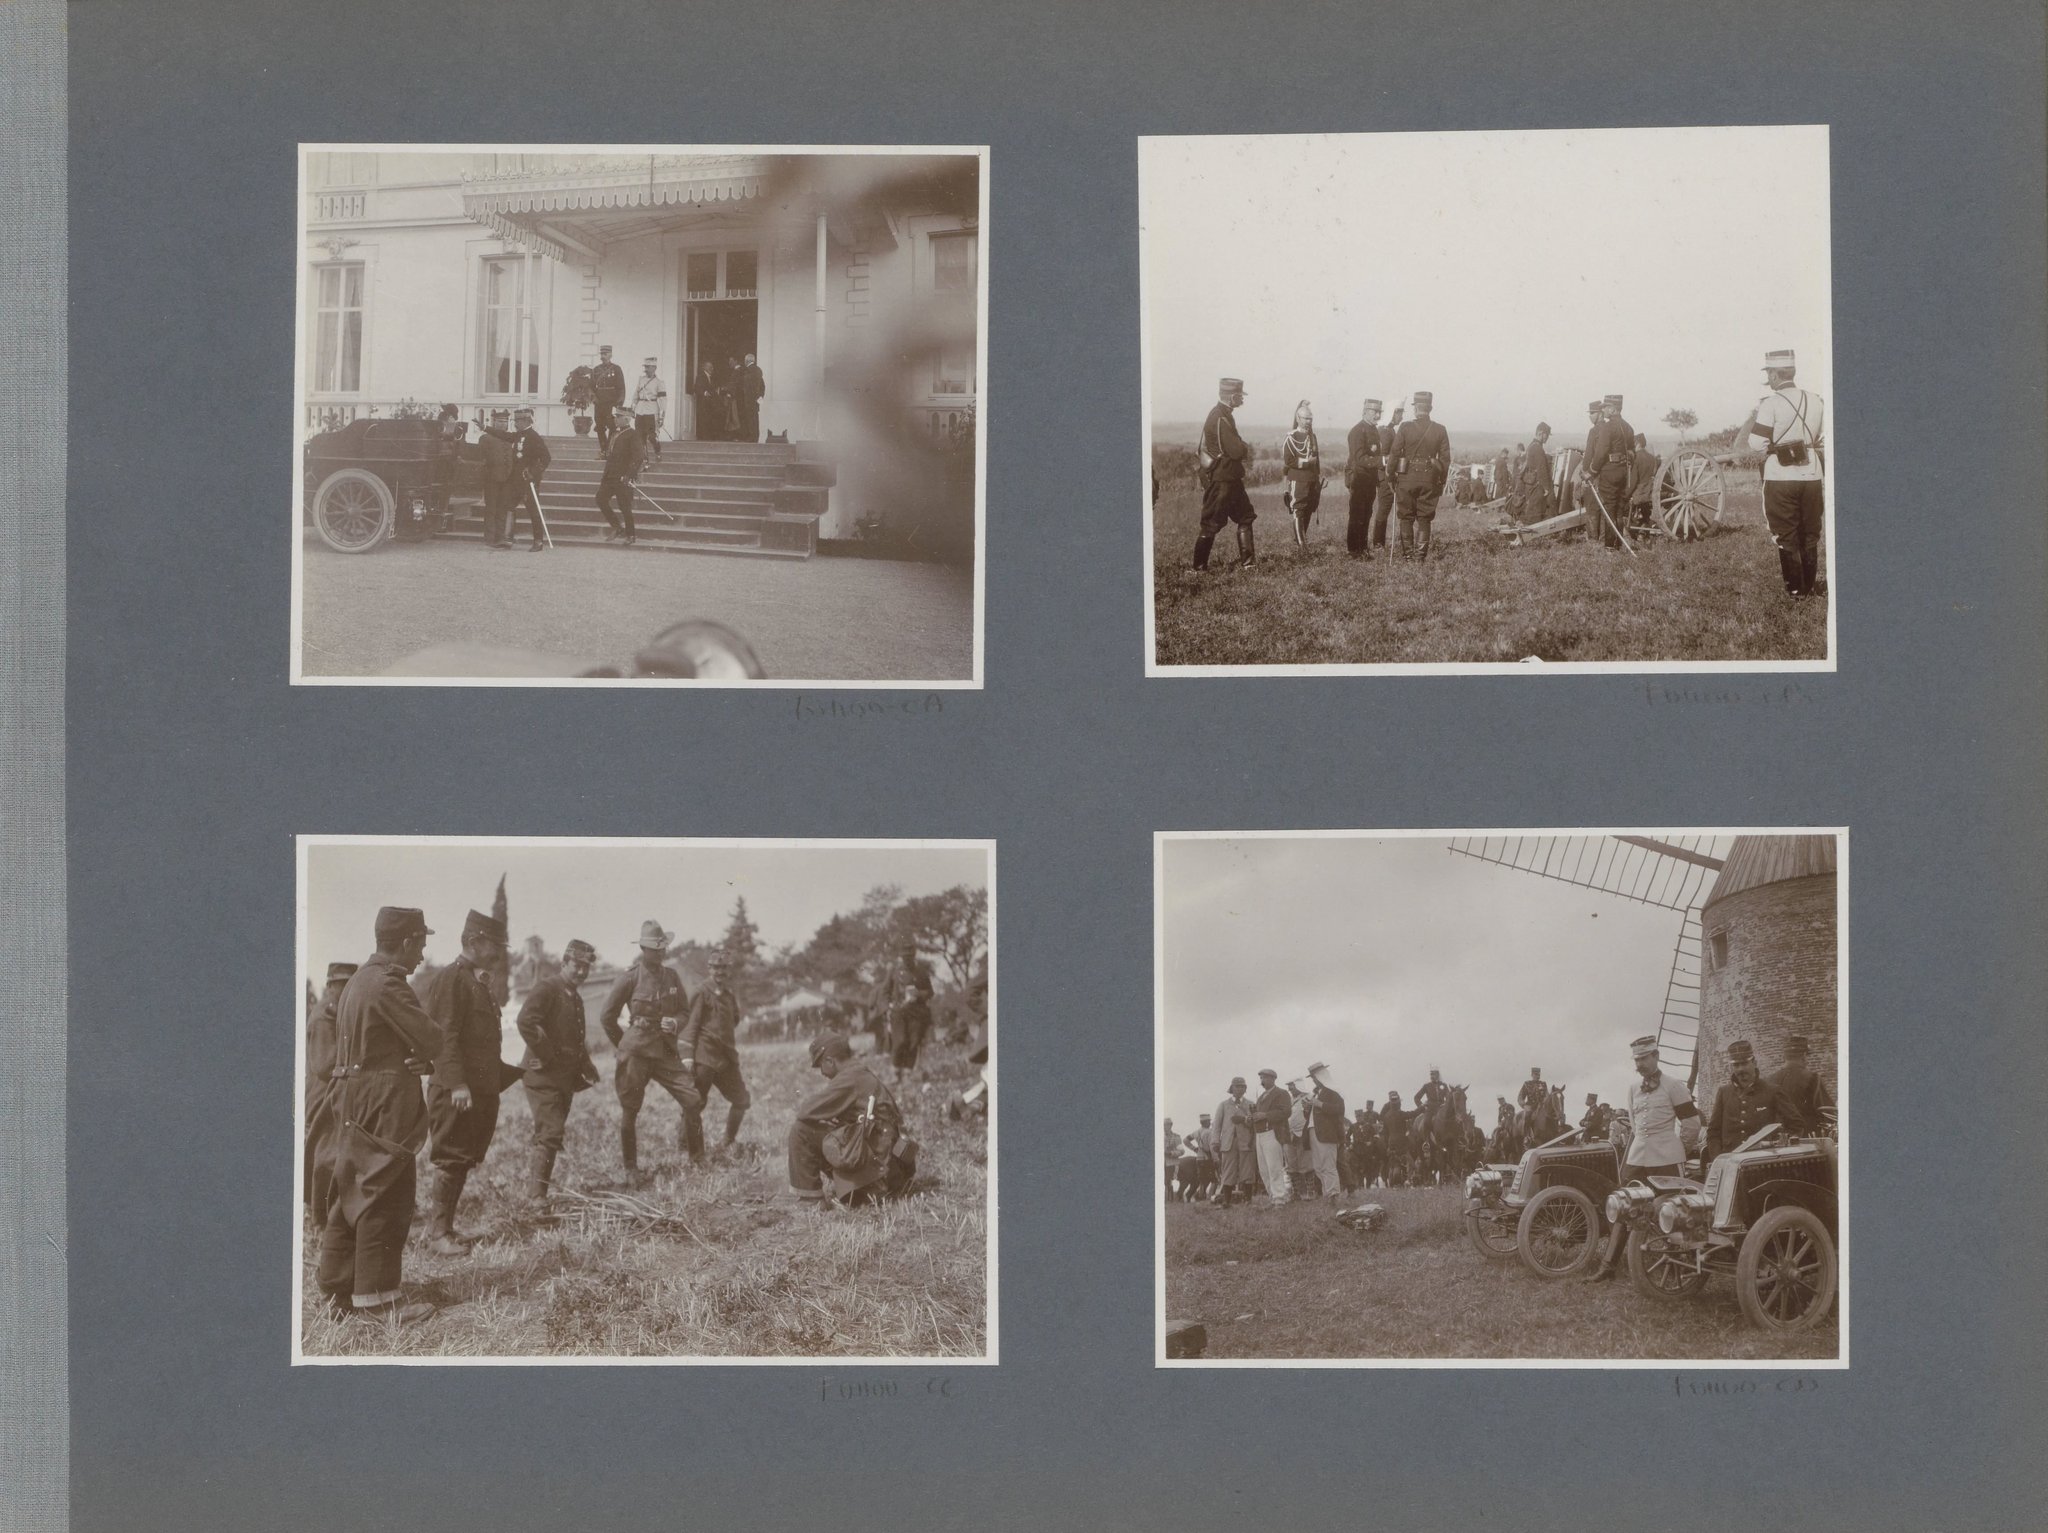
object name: photograph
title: Militairen, auto's en paarden bij een molen in Frankrijk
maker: Anonymous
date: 1902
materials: paper, photographic support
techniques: daylight paper print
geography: france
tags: manoeuvre ~ military training, horse, automobile, windmill, france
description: Onderdeel van Fotoalbum van een legeroefening in Zuidwest-Frankrijk in 1902.